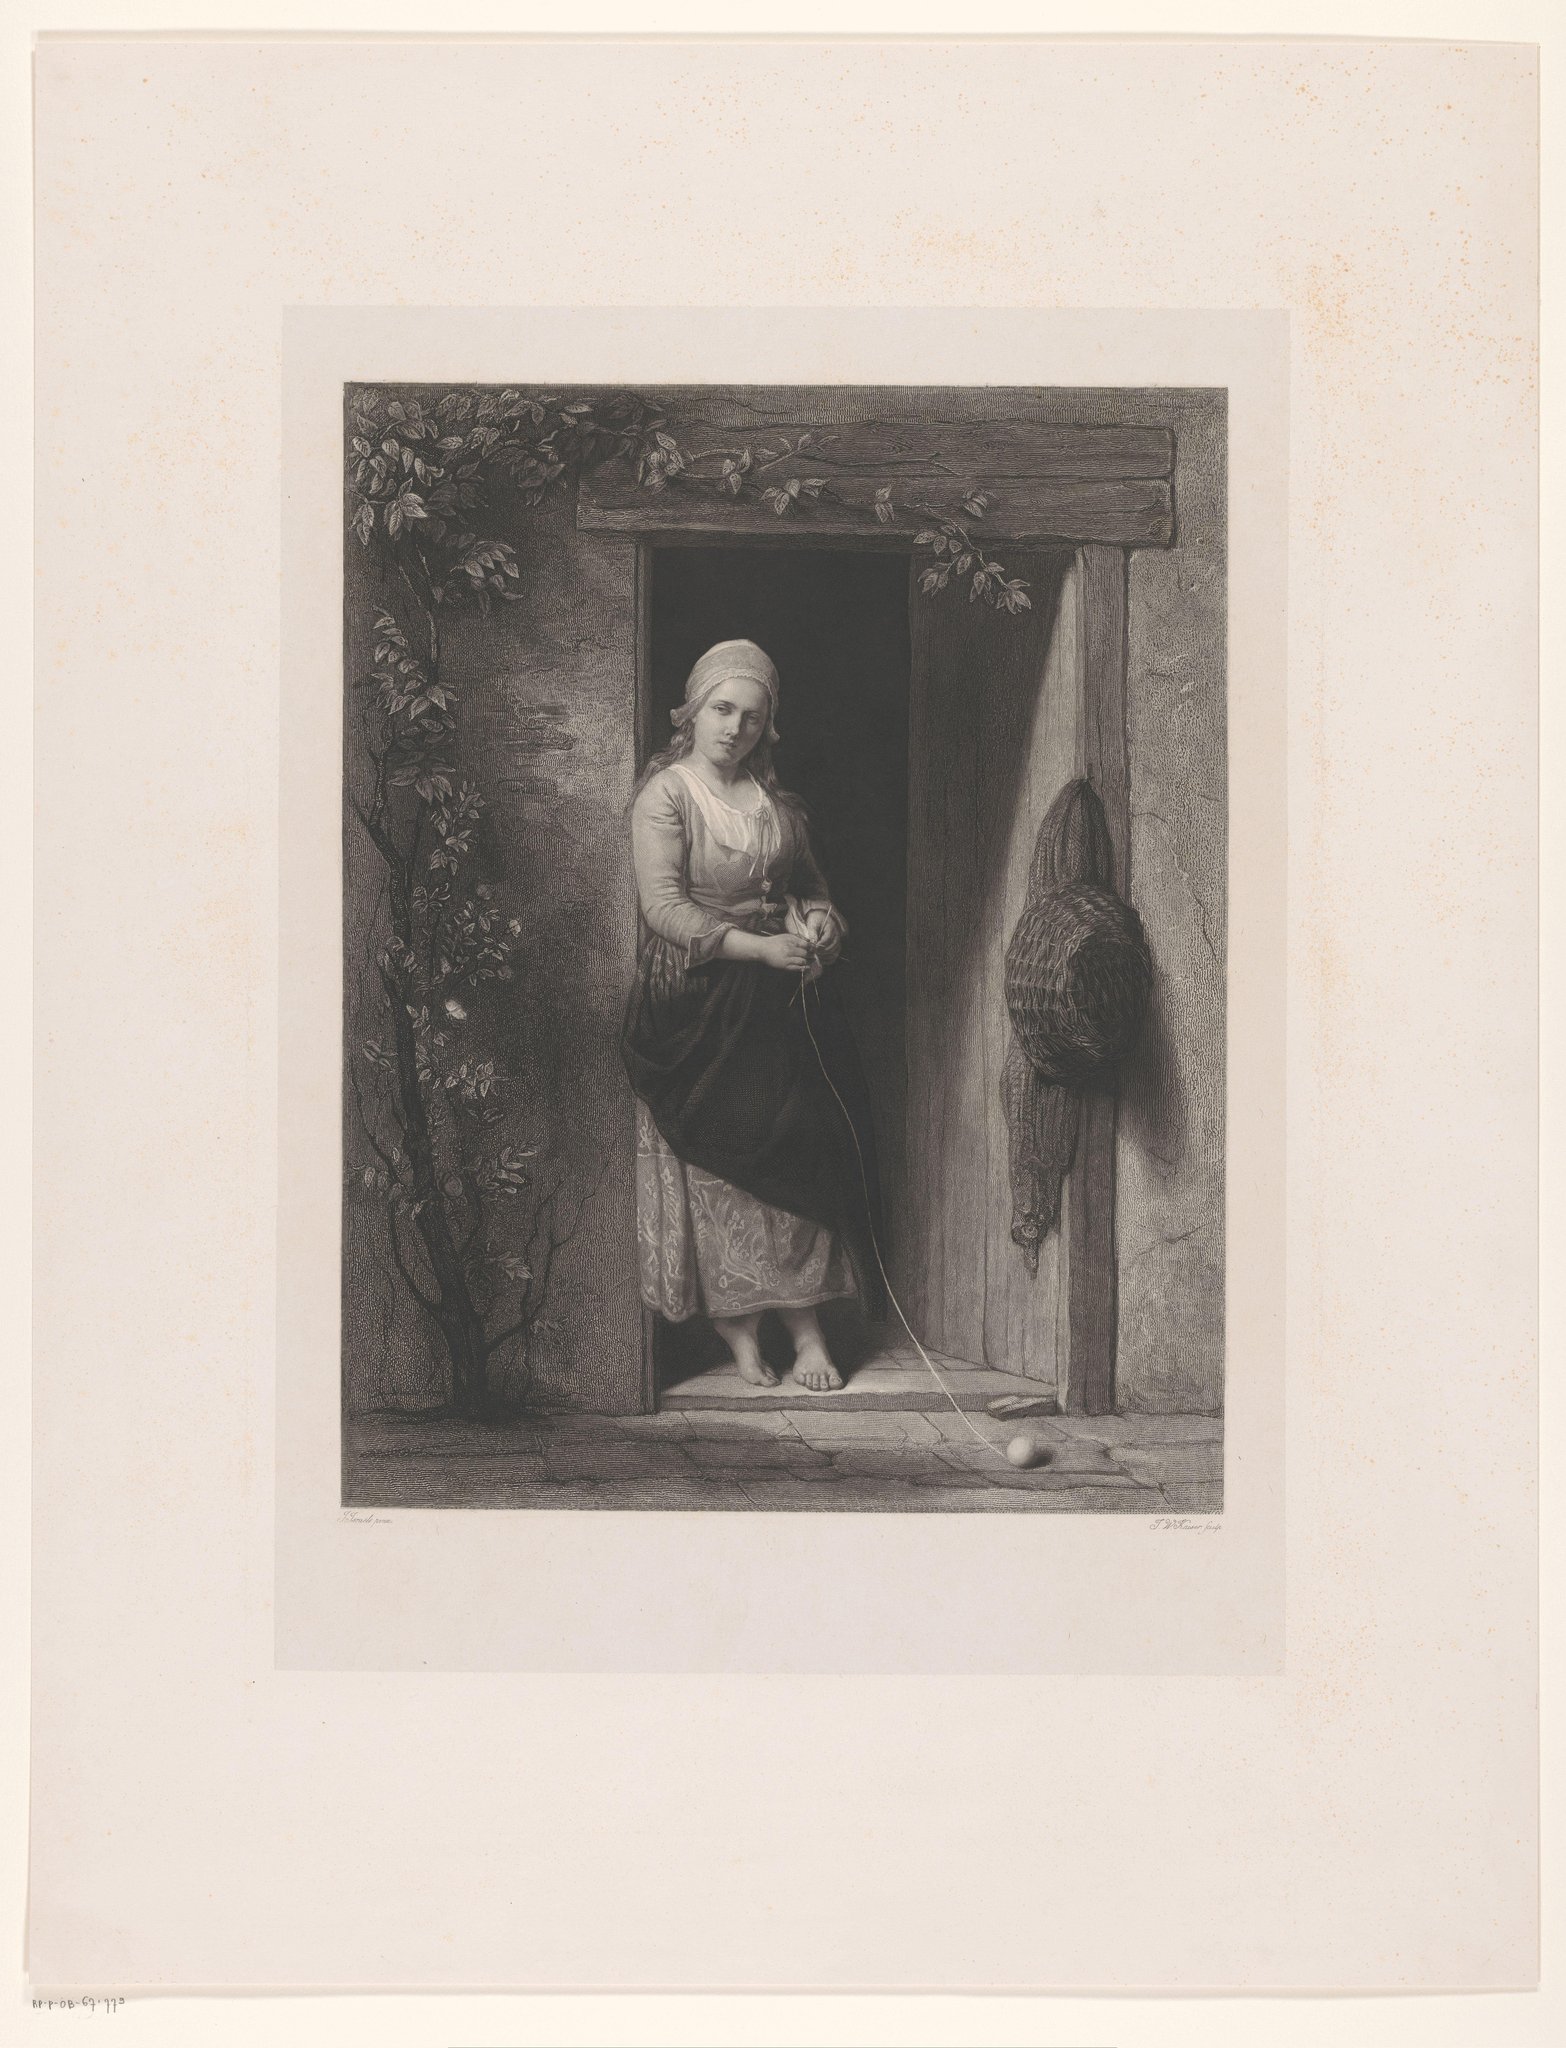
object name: print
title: Jonge vrouw met breiwerk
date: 1823-1900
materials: paper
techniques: aquatint, engraving, etching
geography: netherlands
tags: knitting (+ women (labourers))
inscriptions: collector's mark: Lugt 2165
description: Een jonge vrouw met hoofddeksel staat met een breiwerkje in een deuropening. Voor haar voeten ligt een bol wol.